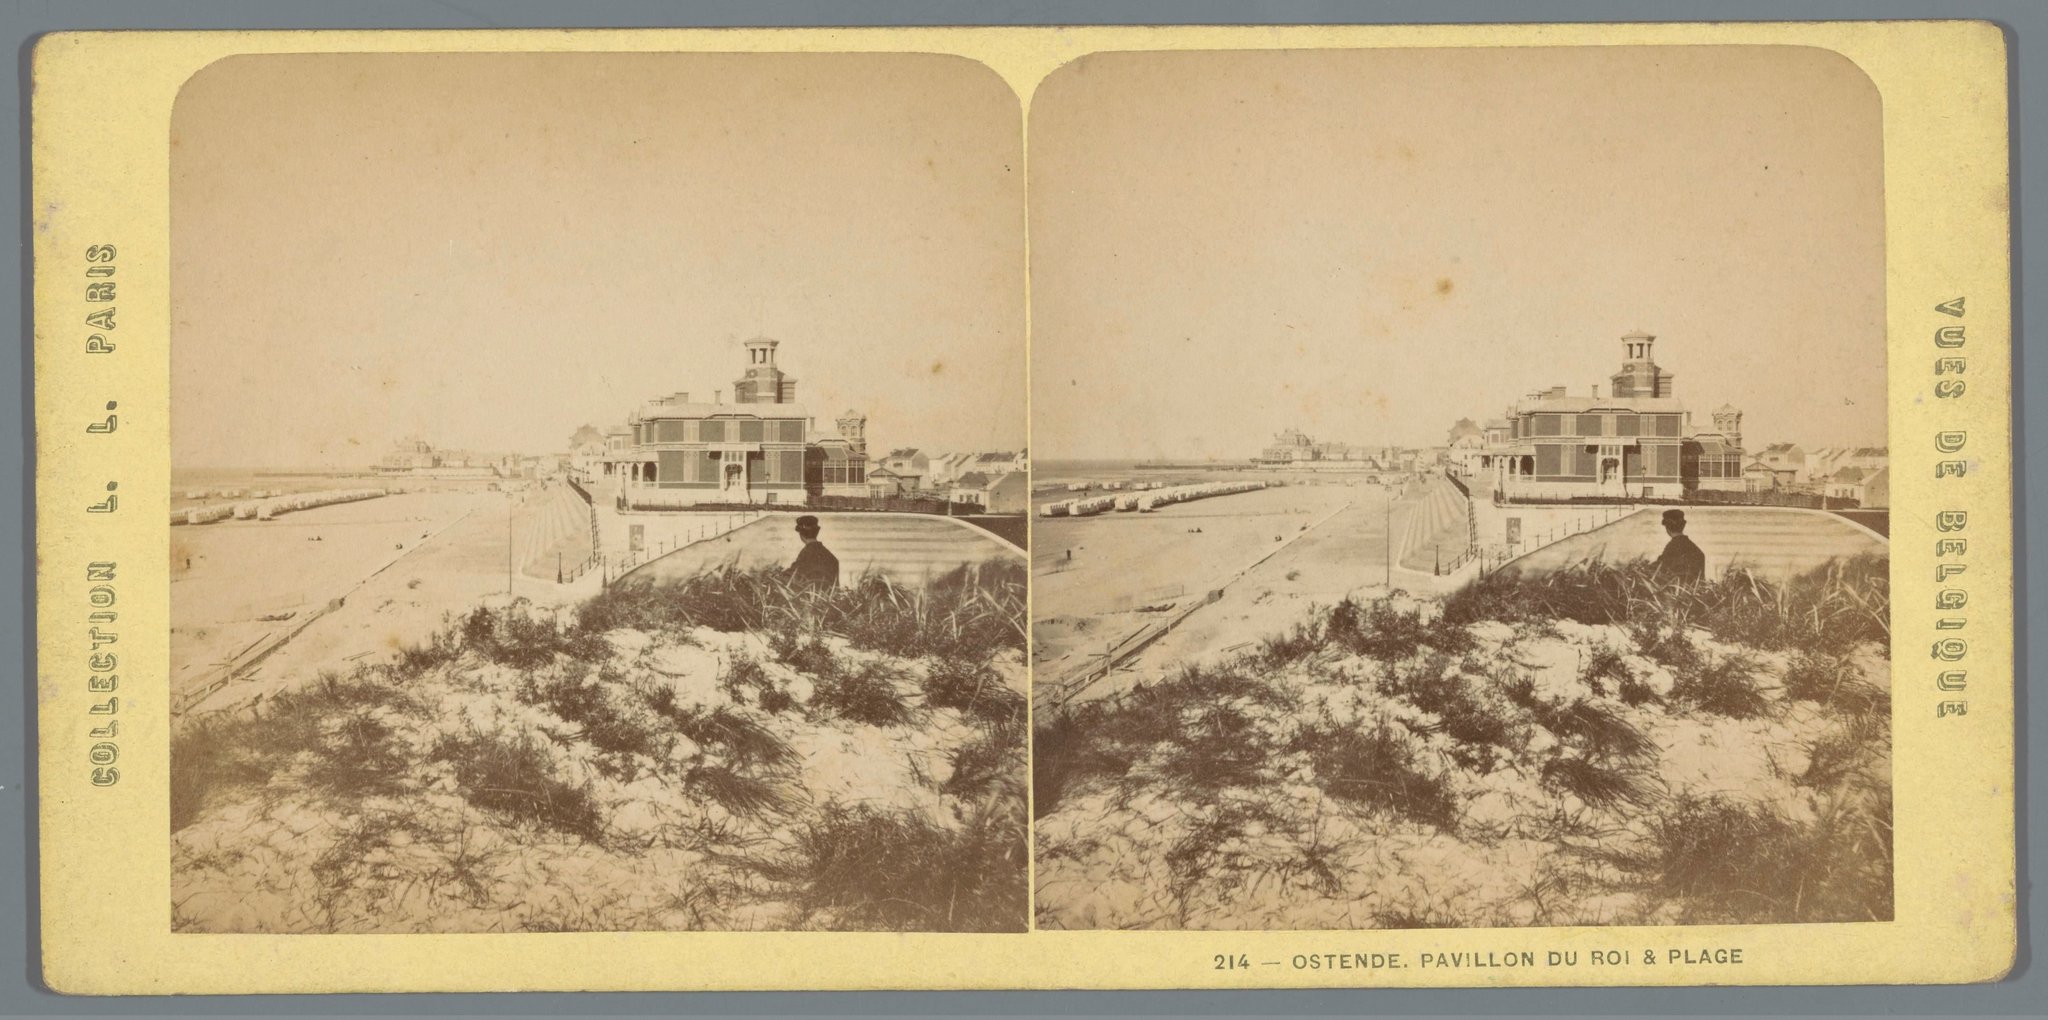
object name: stereograph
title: Ostende. Pavillon du Roi et plage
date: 1873-1890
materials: cardboard, paper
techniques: albumen print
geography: oostende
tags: exterior ~ representation of a building, beach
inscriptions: number: ‘214’, inscription: ‘INGÉNIEURS OPTICIENS DU ROI/ ~~/ Bruxelles. Anvers./ Ostende’